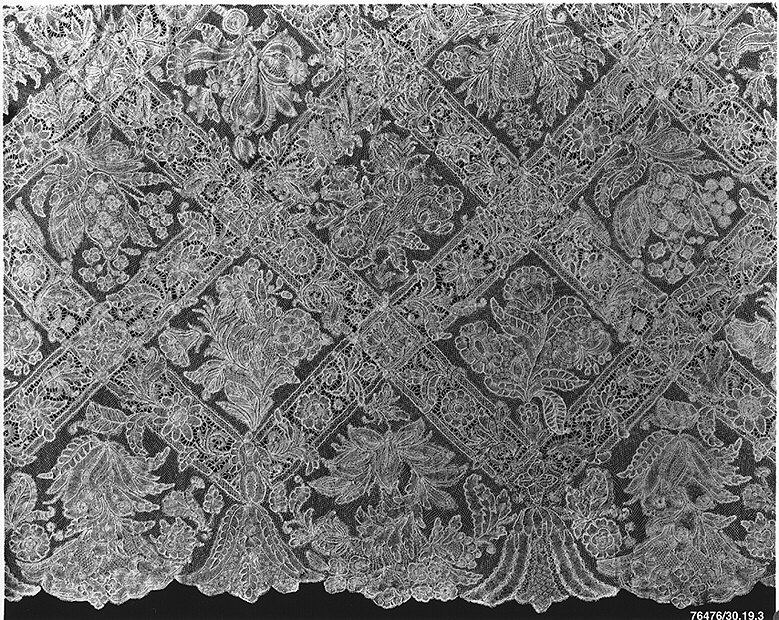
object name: flounce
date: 1701-1733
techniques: lace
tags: flowers